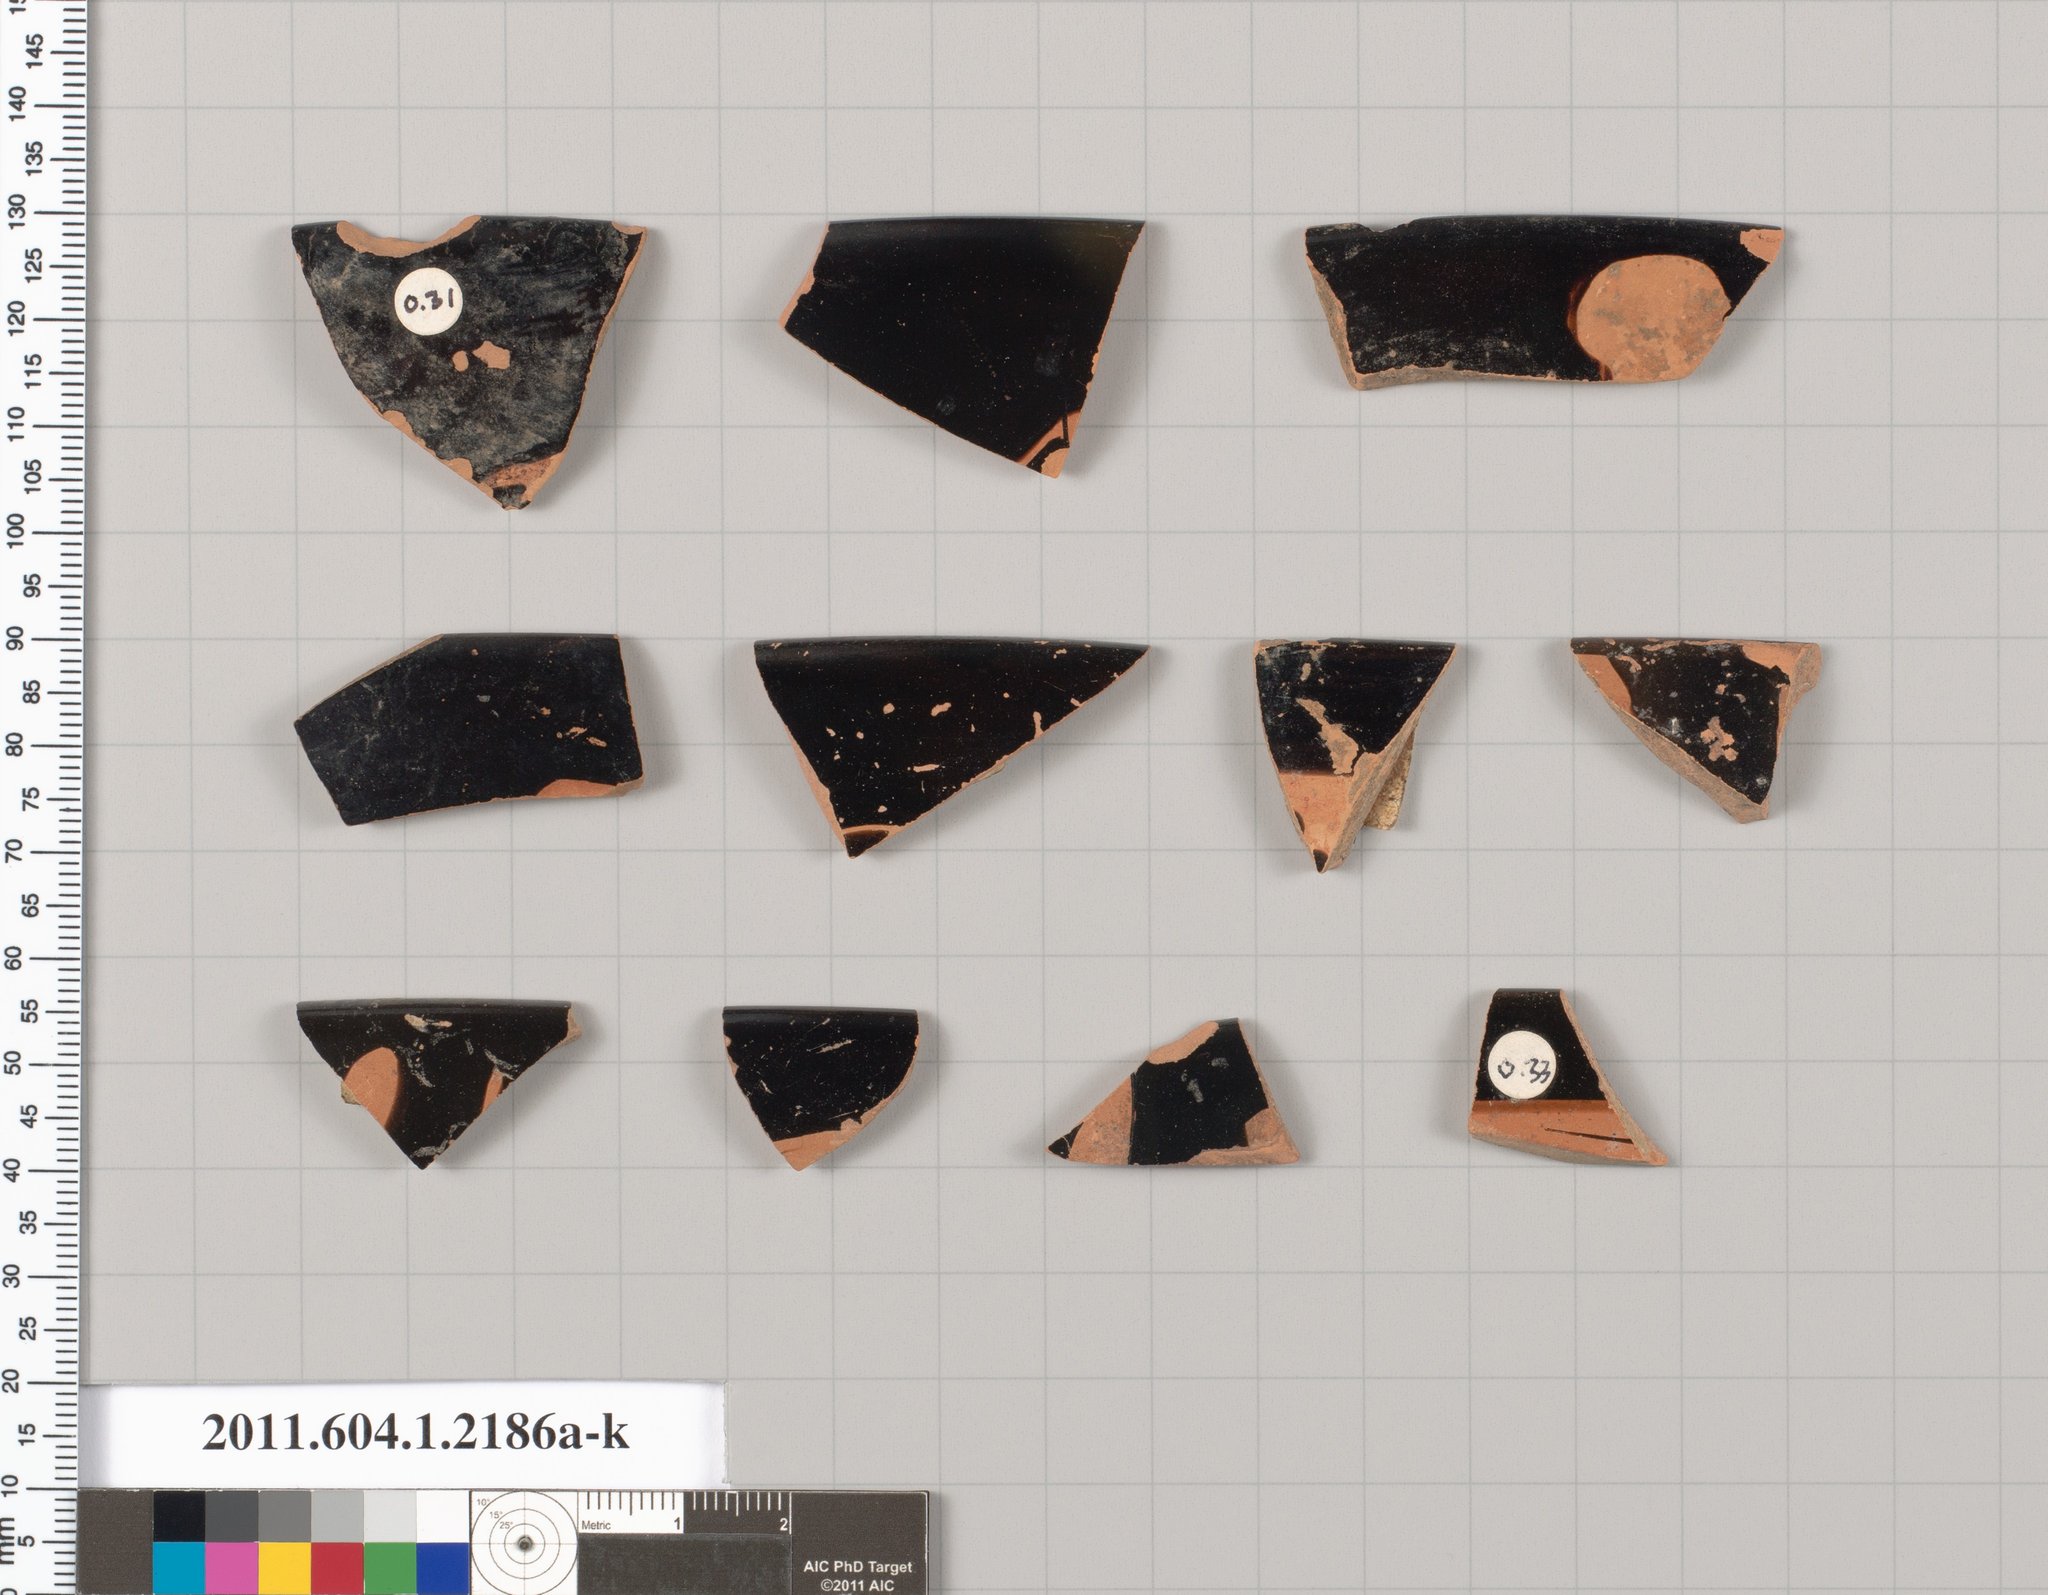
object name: kylix fragment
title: Terracotta rim fragments of kylikes (drinking cups)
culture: greek, attic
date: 401-500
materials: terracotta